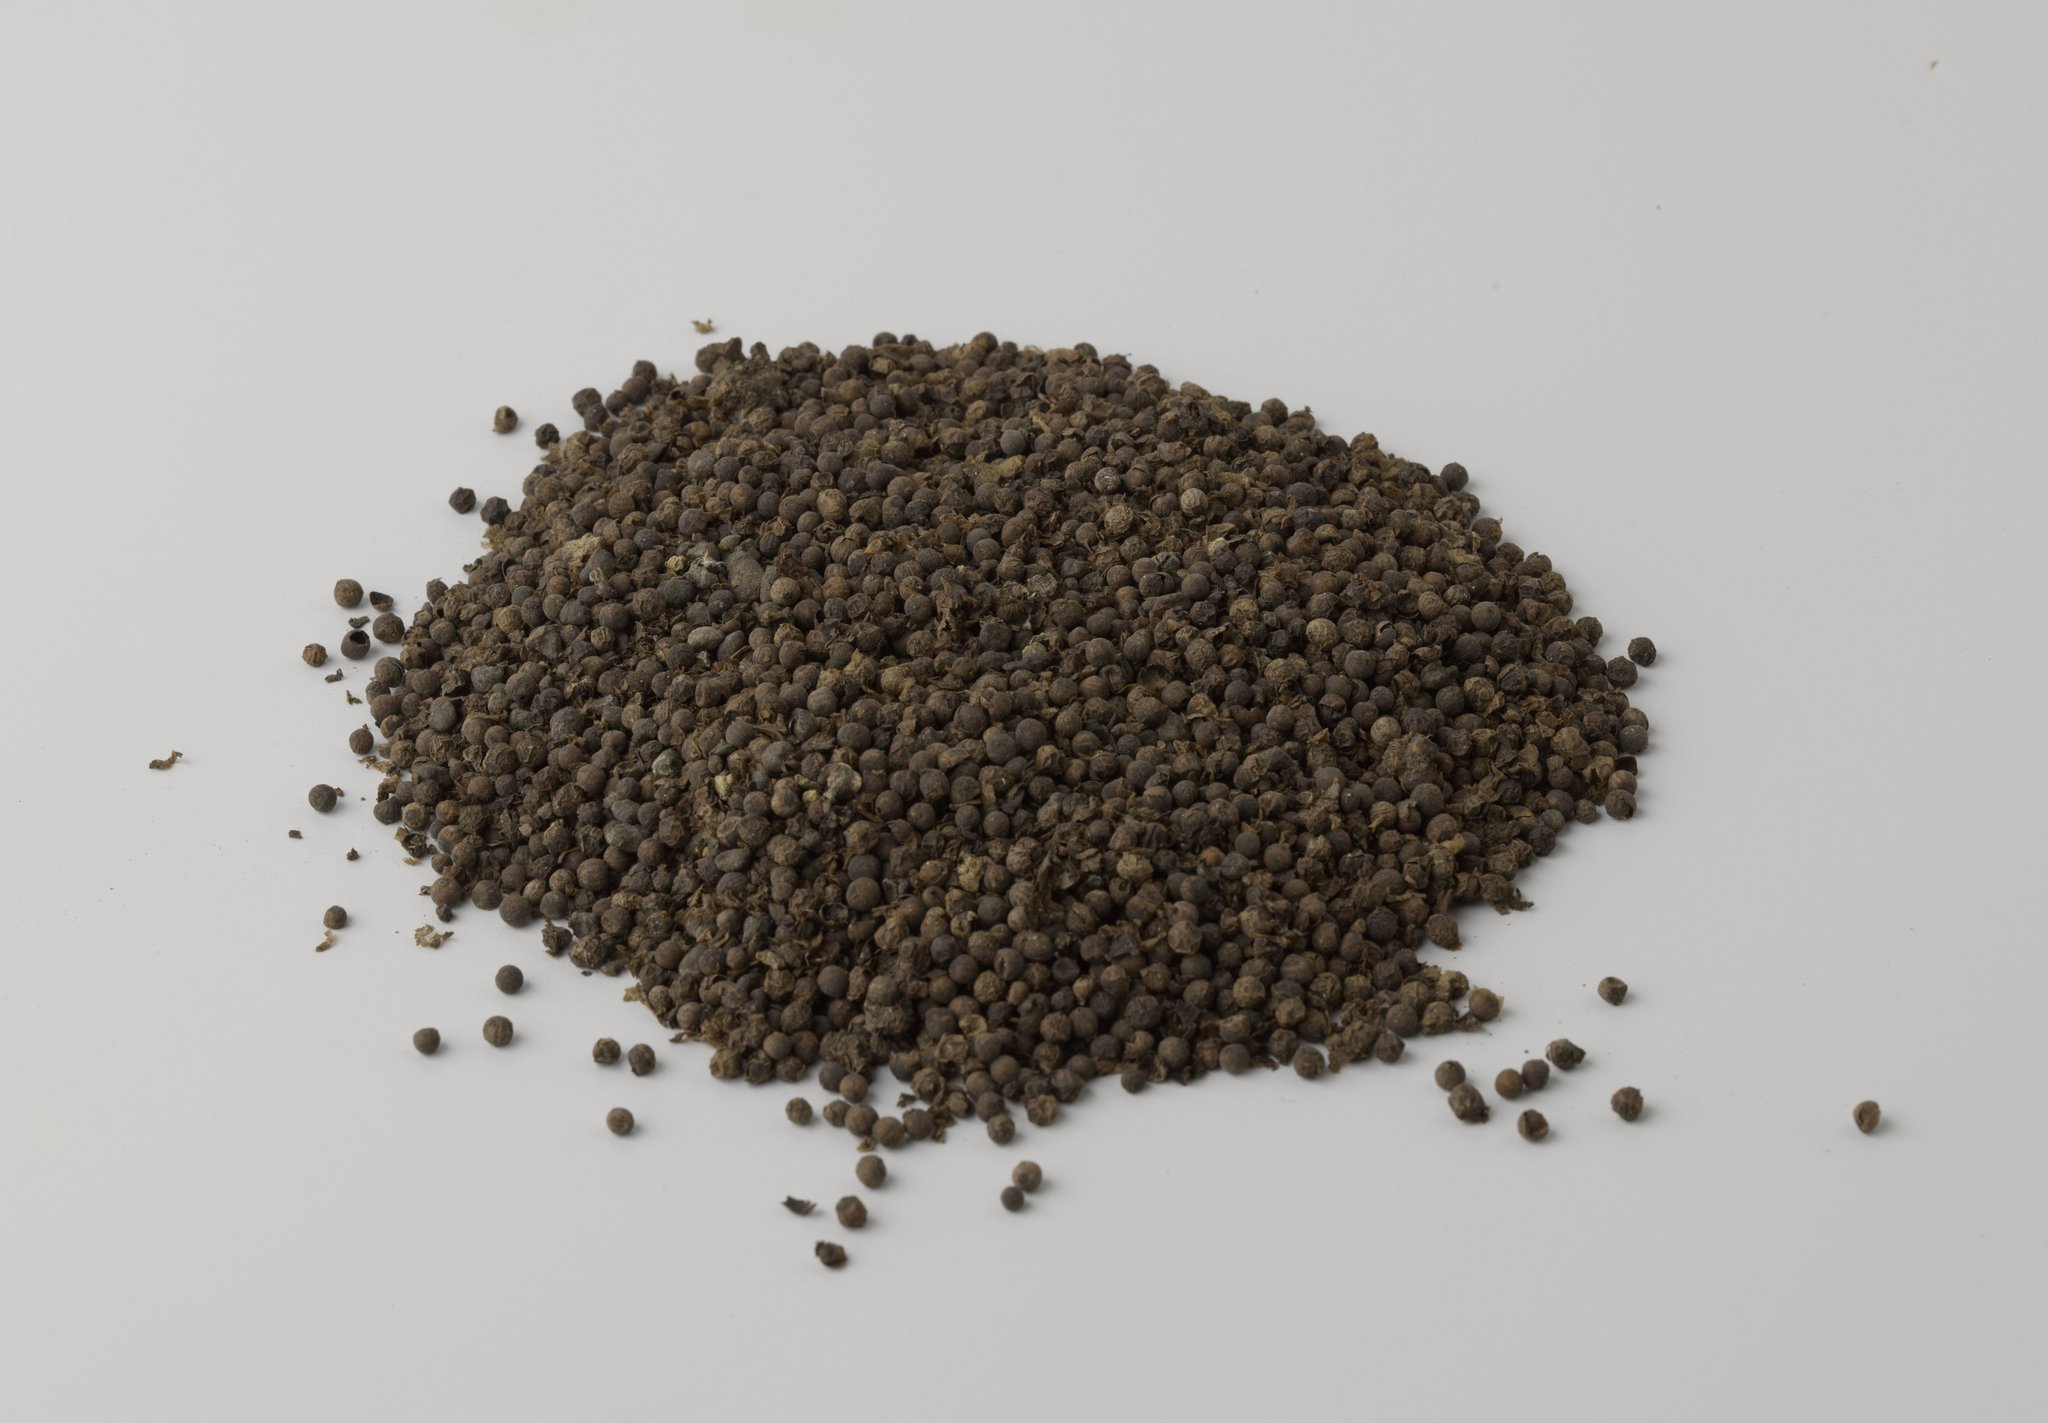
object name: pepper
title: Pepper from the wreck of the Dutch East Indiaman Witte Leeuw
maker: niet van toepassing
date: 1613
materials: spice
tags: verenigde oostindische compagnie, sint-helena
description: Losse peperkorrels, afkomstig uit het wrak van het V.O.C.-schip 'Witte Leeuw'. Volgens de berger van het scheepswrak Robert Sténuit werd veel peper gevonden. Bij het wegzuigen van het afdekkende zand kwam de peper bloot te liggen, die vervolgens door hun lichte gewicht als een donkere wolk in het zeewater vervloog. Deze peperkorrels waren als een klont aan elkaar gekoekt en zijn tijdens het drogen weer los geraakt.